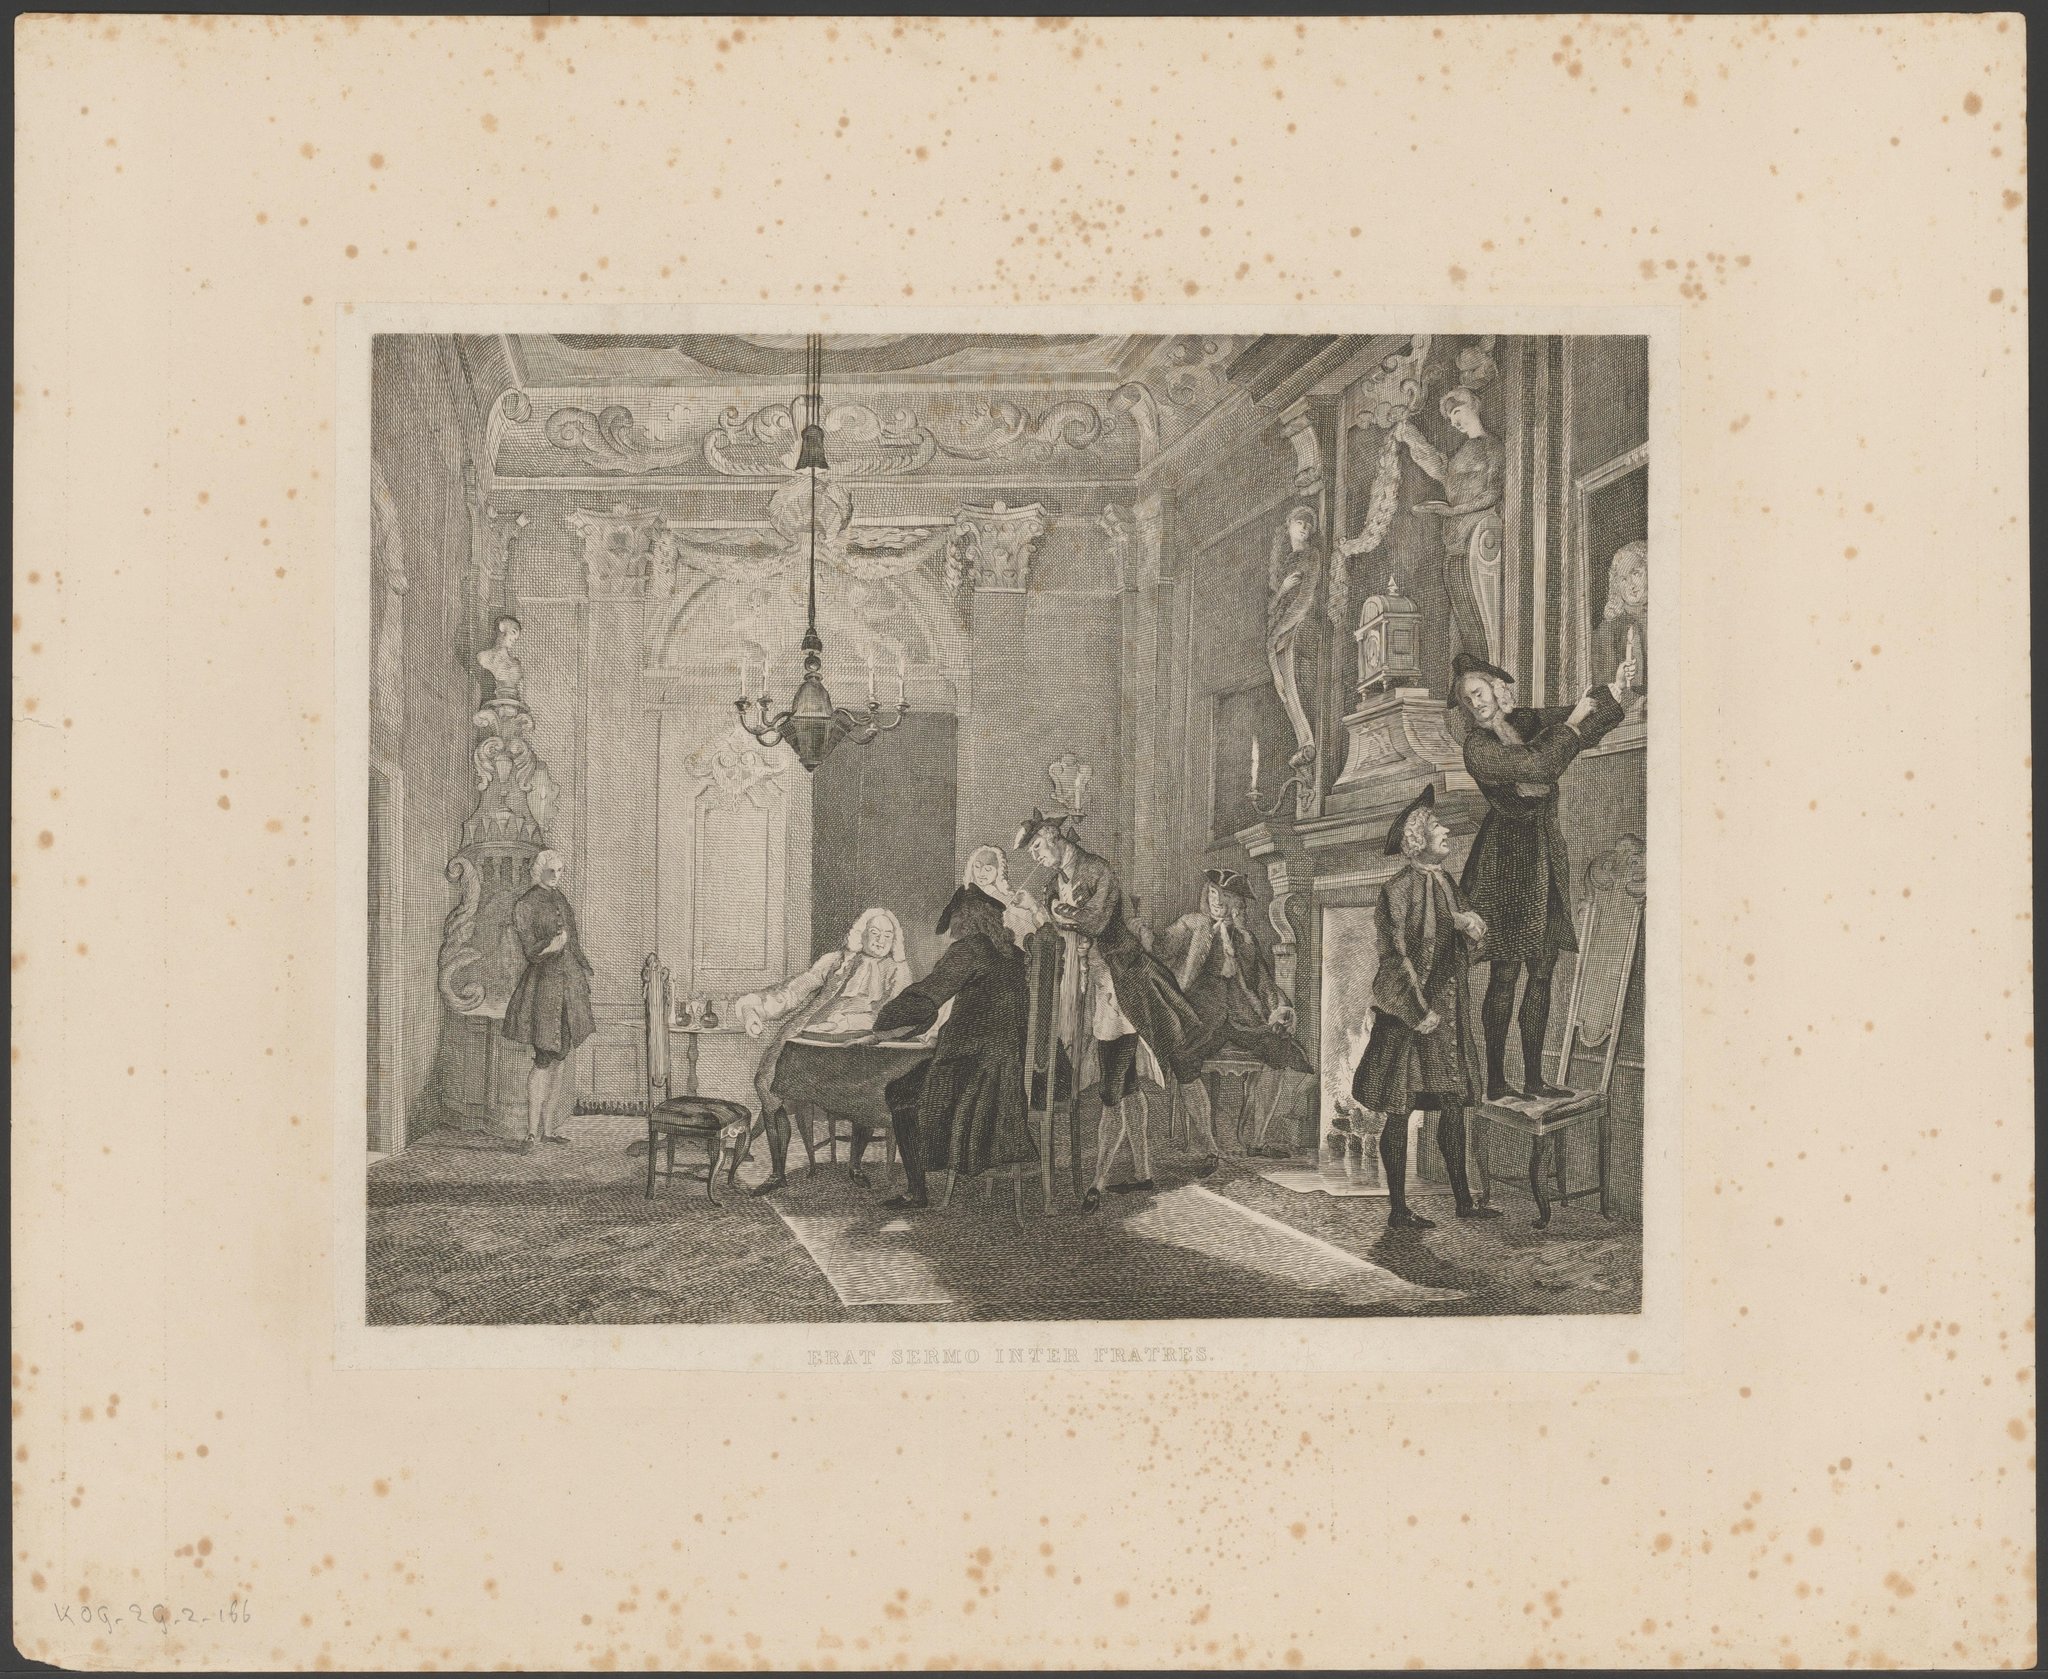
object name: print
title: De Nelri van C. Troost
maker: tieleman cato bruining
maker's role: print maker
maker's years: 1801-1877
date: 1850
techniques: printmaking, etching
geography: leiden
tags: drawing-room, 'salon', drinks, stimulants, drugs (+ taking (particular) foodstuffs: eating, drinking, smoking, chewing, etc.), board-games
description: Een groep heren is bijeen in een rooksalon. Twee mannen spelen een bordspel en twee anderen kijken toe. De klok boven de open haard staat op 8 uur. Rechts op de voorgrond staat een man op een stoel om een ander een detail op een schilderij aan te wijzen. Behoort bij de omslag voor de Nelri-prentenserie in zes exemplaren en het tekstblad met toelichting.